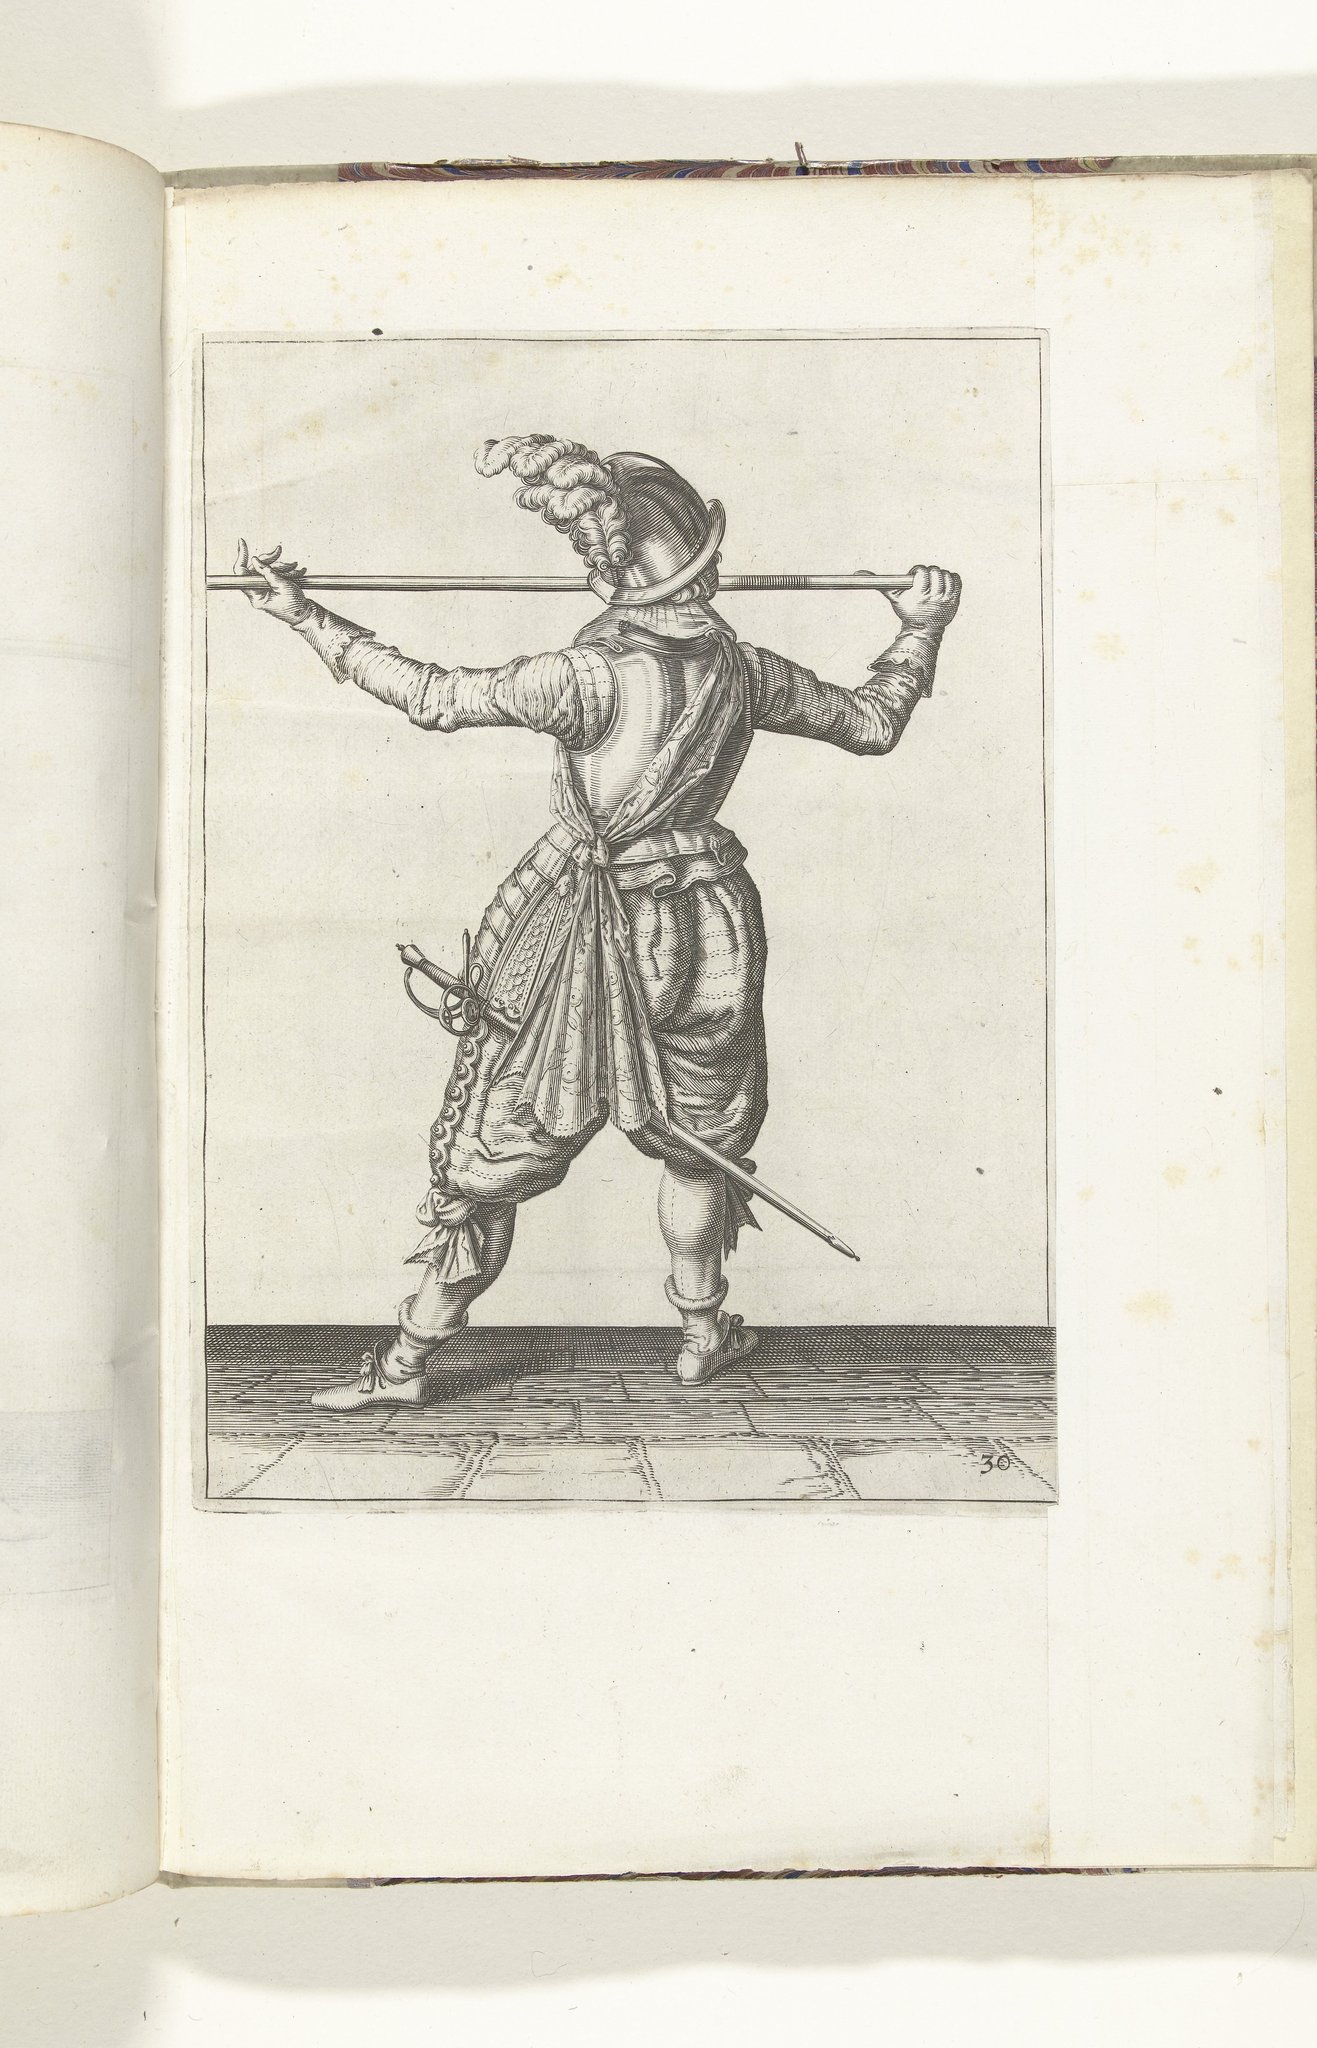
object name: print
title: Soldaat, op de rug gezien, die zijn spies met beide handen horizontaal op neushoogte draagt, zijn rechterhand bij de voet van het wapen, zijn gezicht naar rechts gewend (nr. 30), ca. 1600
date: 1597-1607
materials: paper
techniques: engraving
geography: northern netherlands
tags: the hague, maurice (prince of orange), handling of weapons ~ military training, weapons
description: Een soldaat, ten voeten uit, op de rug gezien, die een spies (lans) met beide handen horizontaal op neushoogte draagt, zijn rechterhand bij de voet van het wapen, zijn gezicht naar rechts gewend (nr. 30), ca. 1600. Plaat 30 in de instructies voor het hanteren van de spies: Corte onderwysinghe op de figuerliicke afbeeldinghe belanghende trechte gebruck, van alle t'ghene een Soldaet int handelen vande Spies noodich is. Onderdeel van de illustraties in: J. de Gheyn, Wapenhandelinghe van Roers Musquetten ende spiessen, Amsterdam, 1608. Krijgswezen rond 1600.